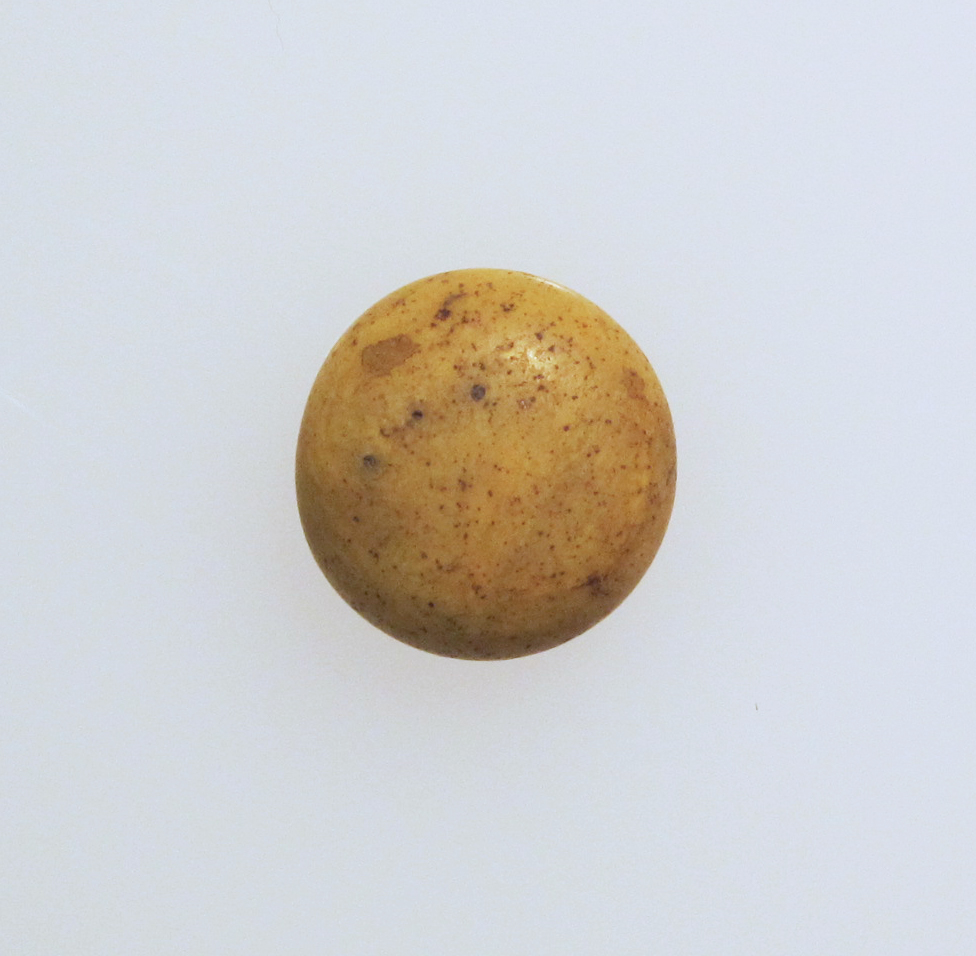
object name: pinhead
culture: roman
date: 100 BCE-500 CE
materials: glass